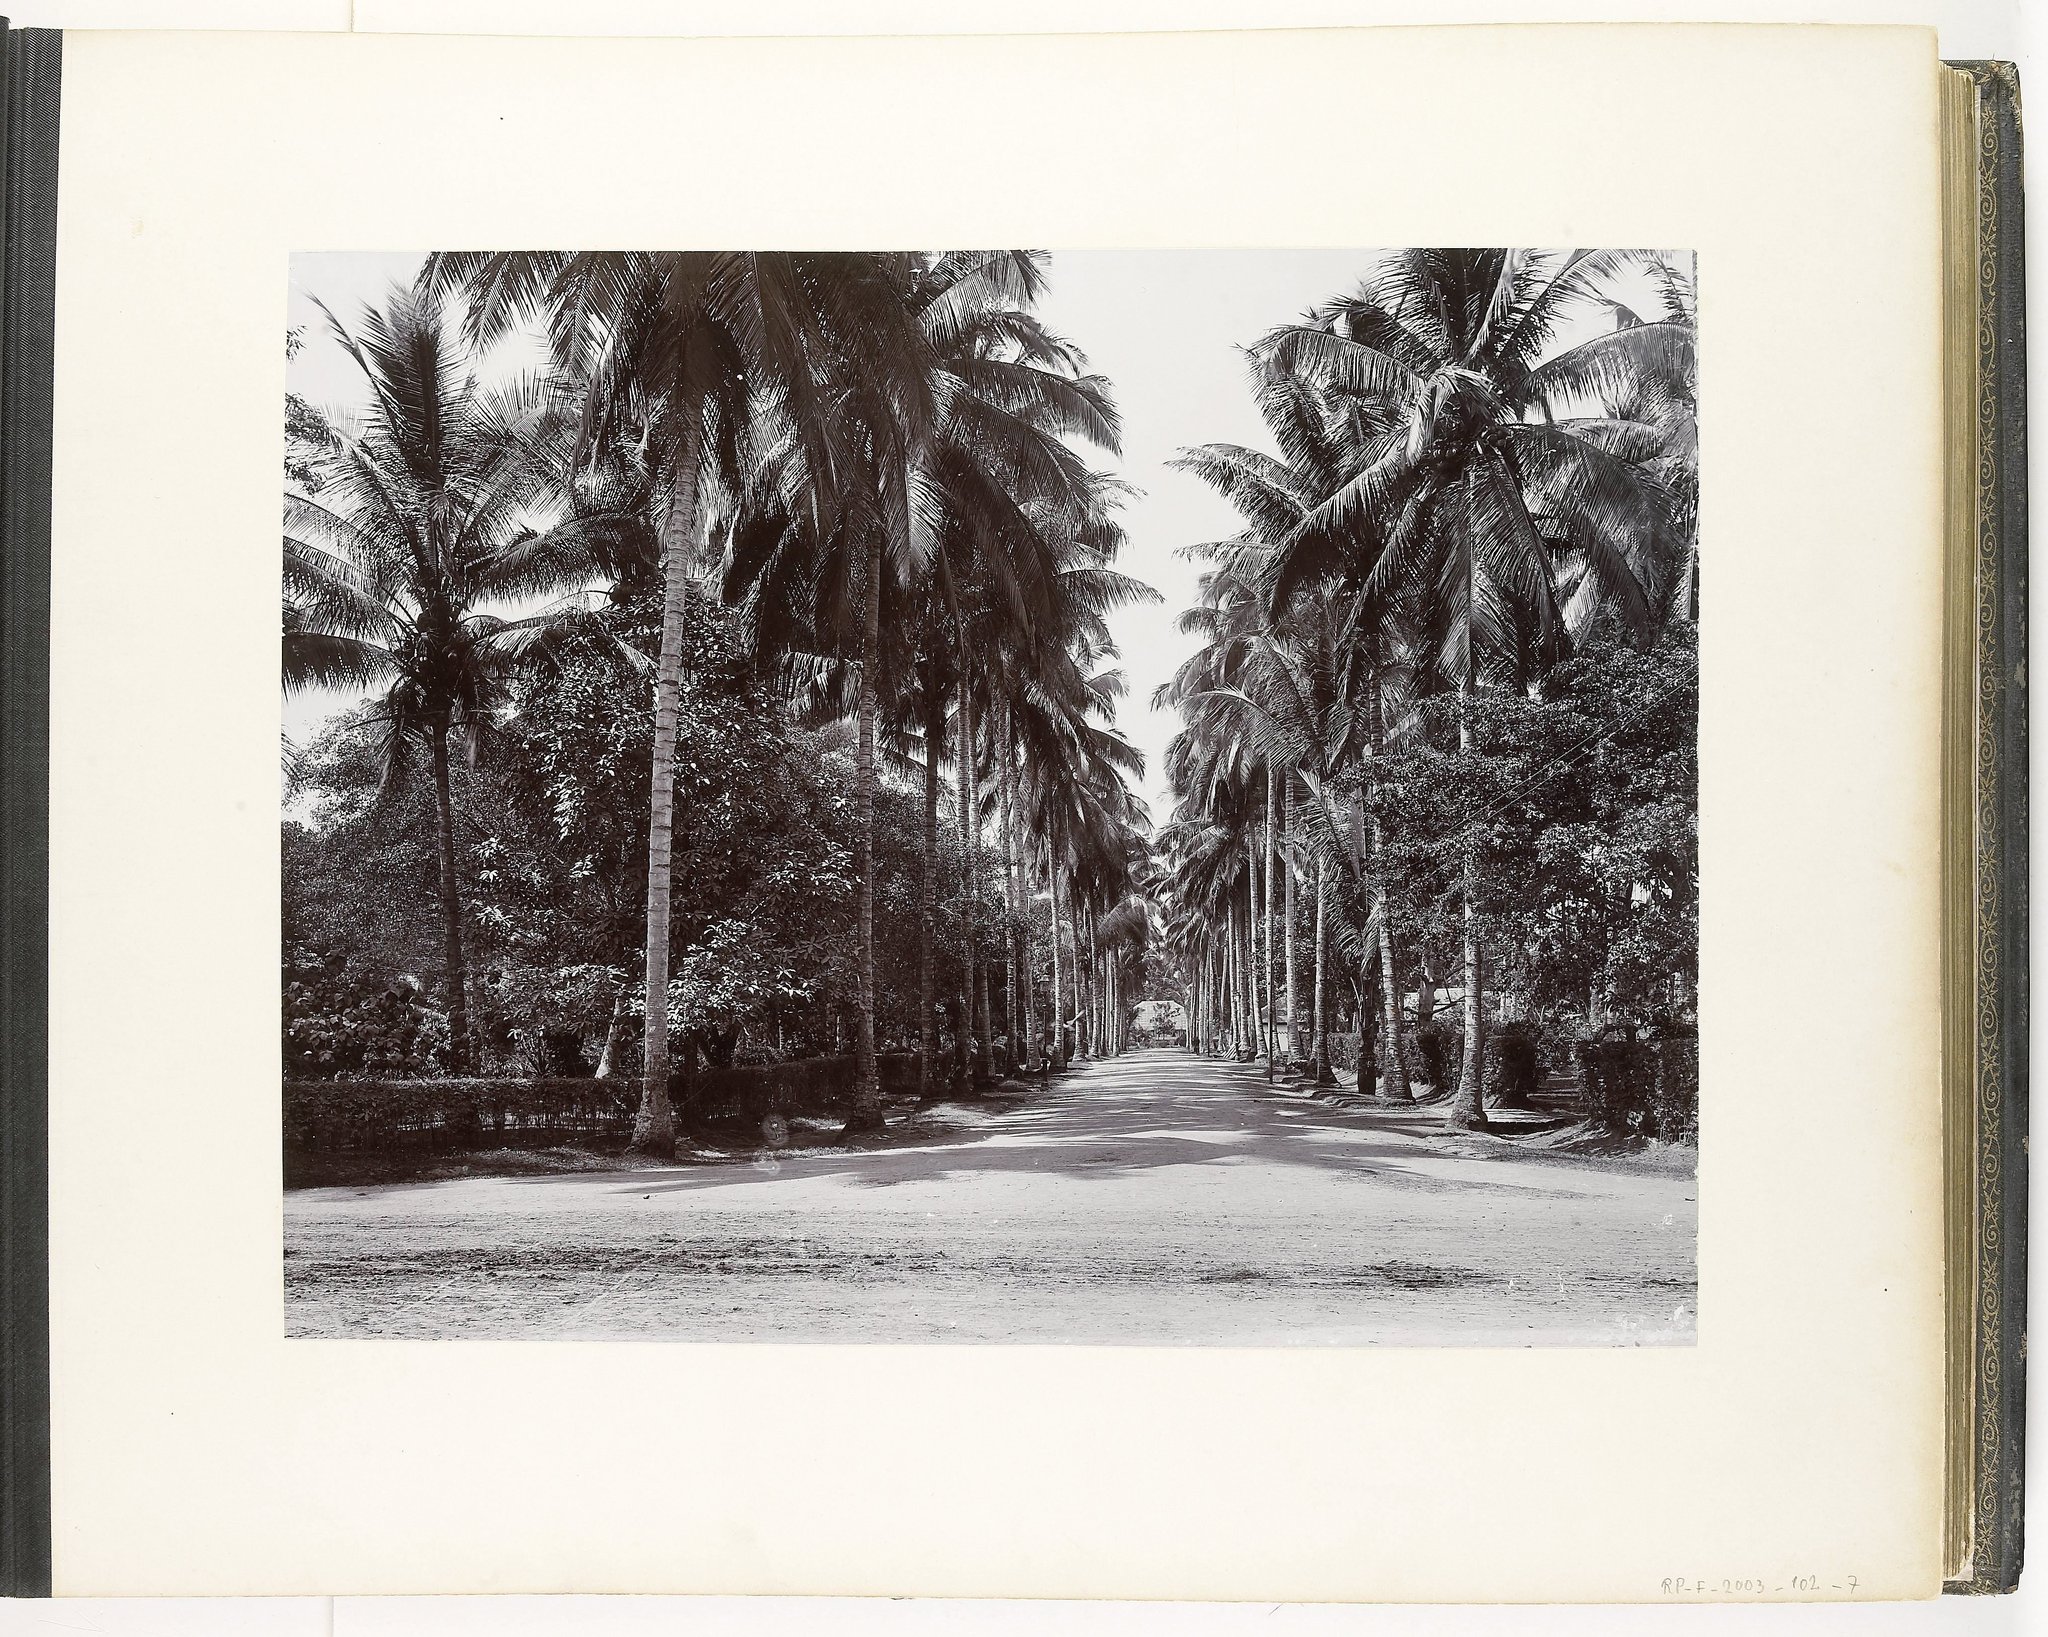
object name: photograph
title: Gezicht langs de Deli Maatschappijlaan, Medan, Sumatra (Deli Mij. Laan)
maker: carl j. kleingrothe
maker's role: fotograaf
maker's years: 1864-1925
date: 1885-1900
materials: photographic support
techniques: collodion silver print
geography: medan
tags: deli maatschappij, medan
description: Gezicht langs de Deli Maatschappijlaan of Delilaan te Medan. Laan met aan weerszijden hoge palmen, op de achtergrond de hoofdadminstrateurswoning van de Deli Maatschappij. Onderdeel van het Sumatra fotoalbum van Paul en Lucie Sandel uit 1900.